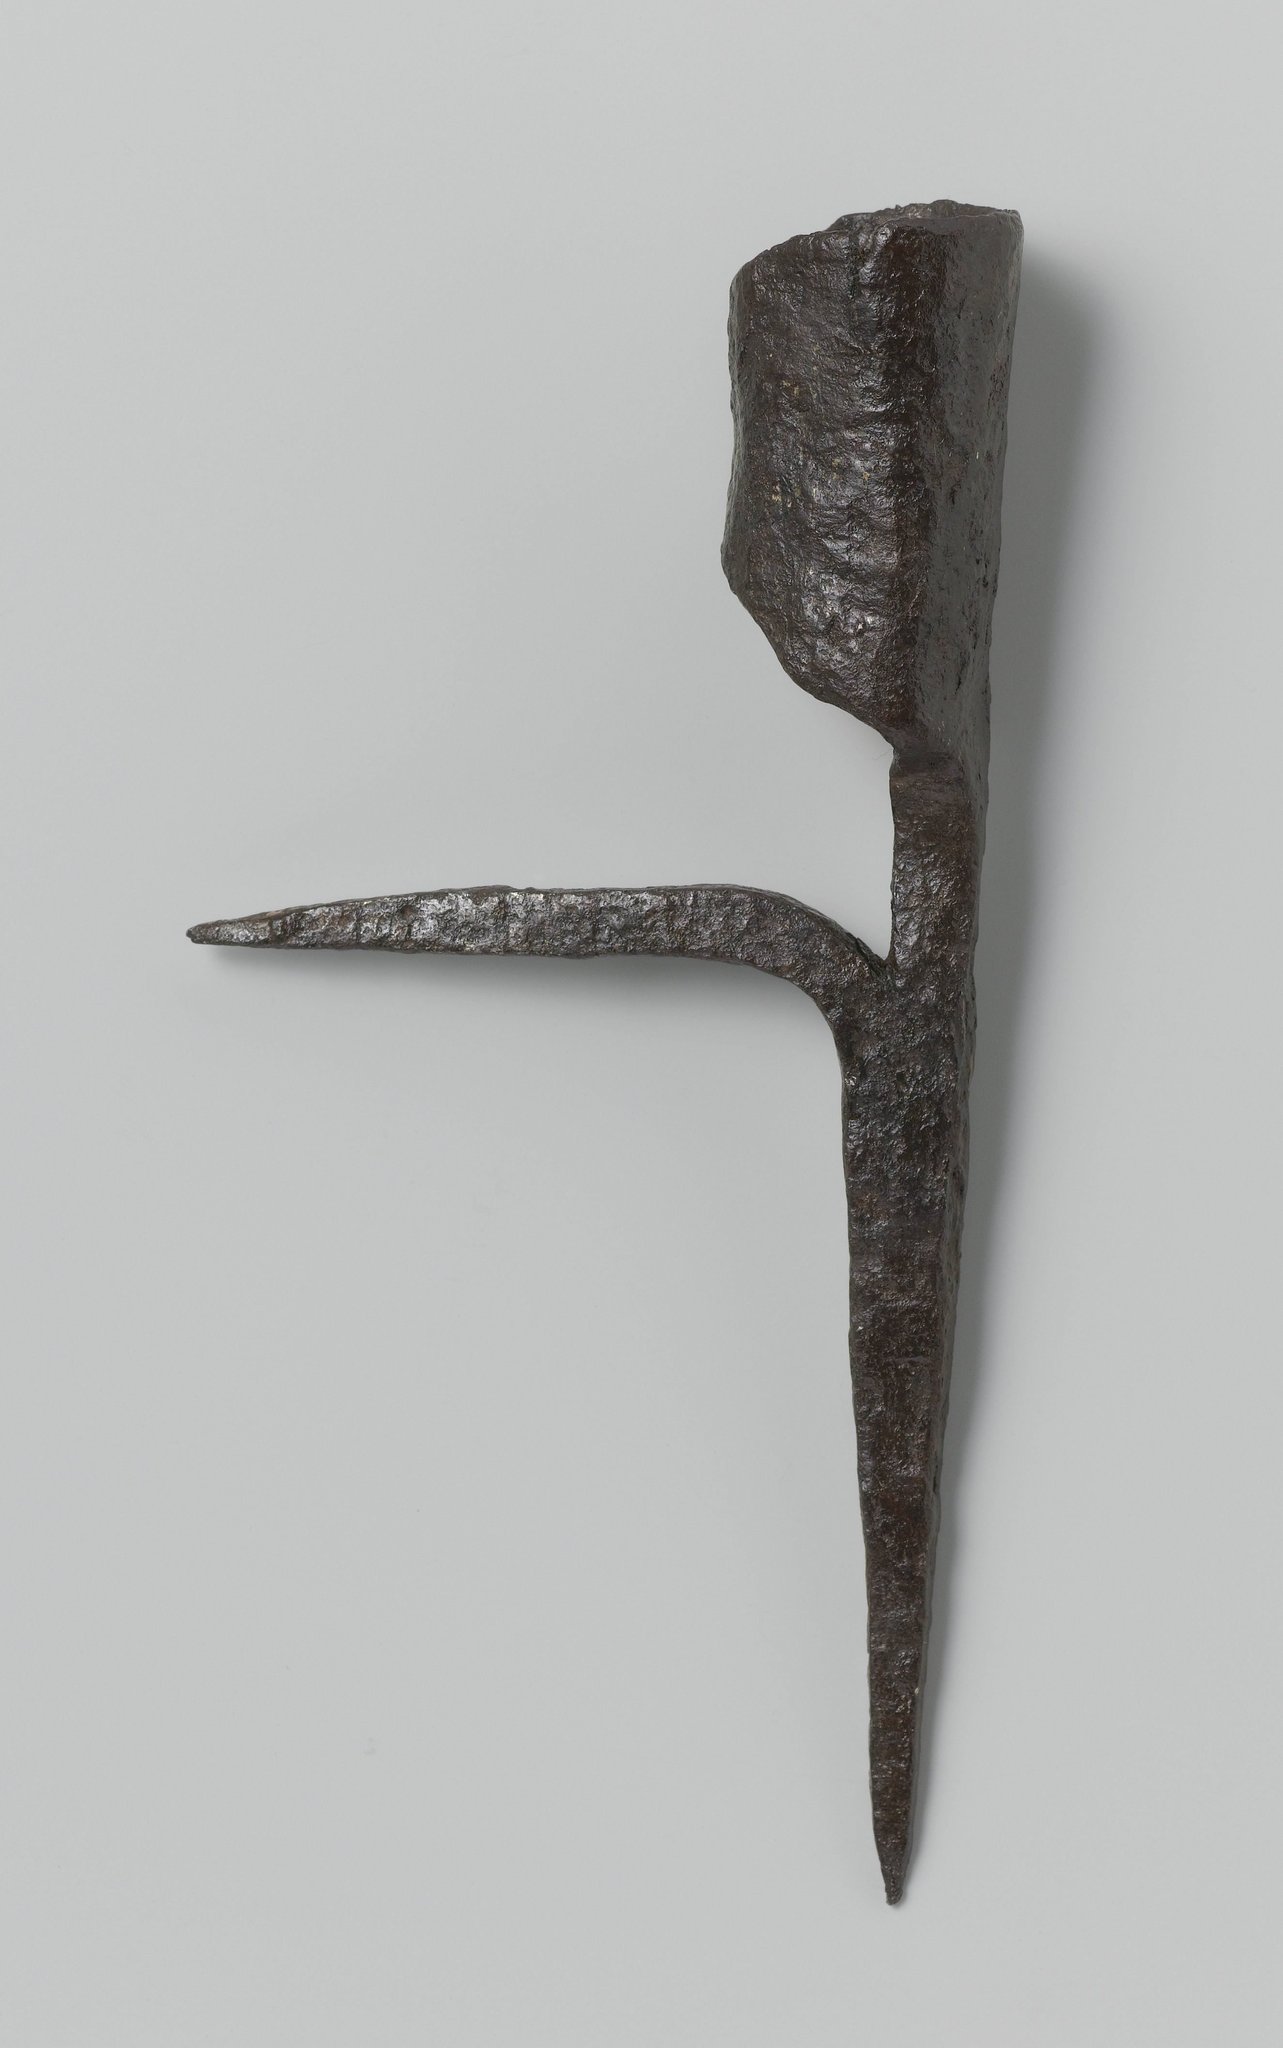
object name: kaarsenhouder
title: Kaarsenhouder bestaande uit een huls voor een kaars en twee loodrecht op elkaar staande pinnen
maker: Anonymous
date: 1590-1596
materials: iron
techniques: forging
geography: amsterdam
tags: willem barendsz., amsterdam, jacob van heemskerck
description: Candle holders